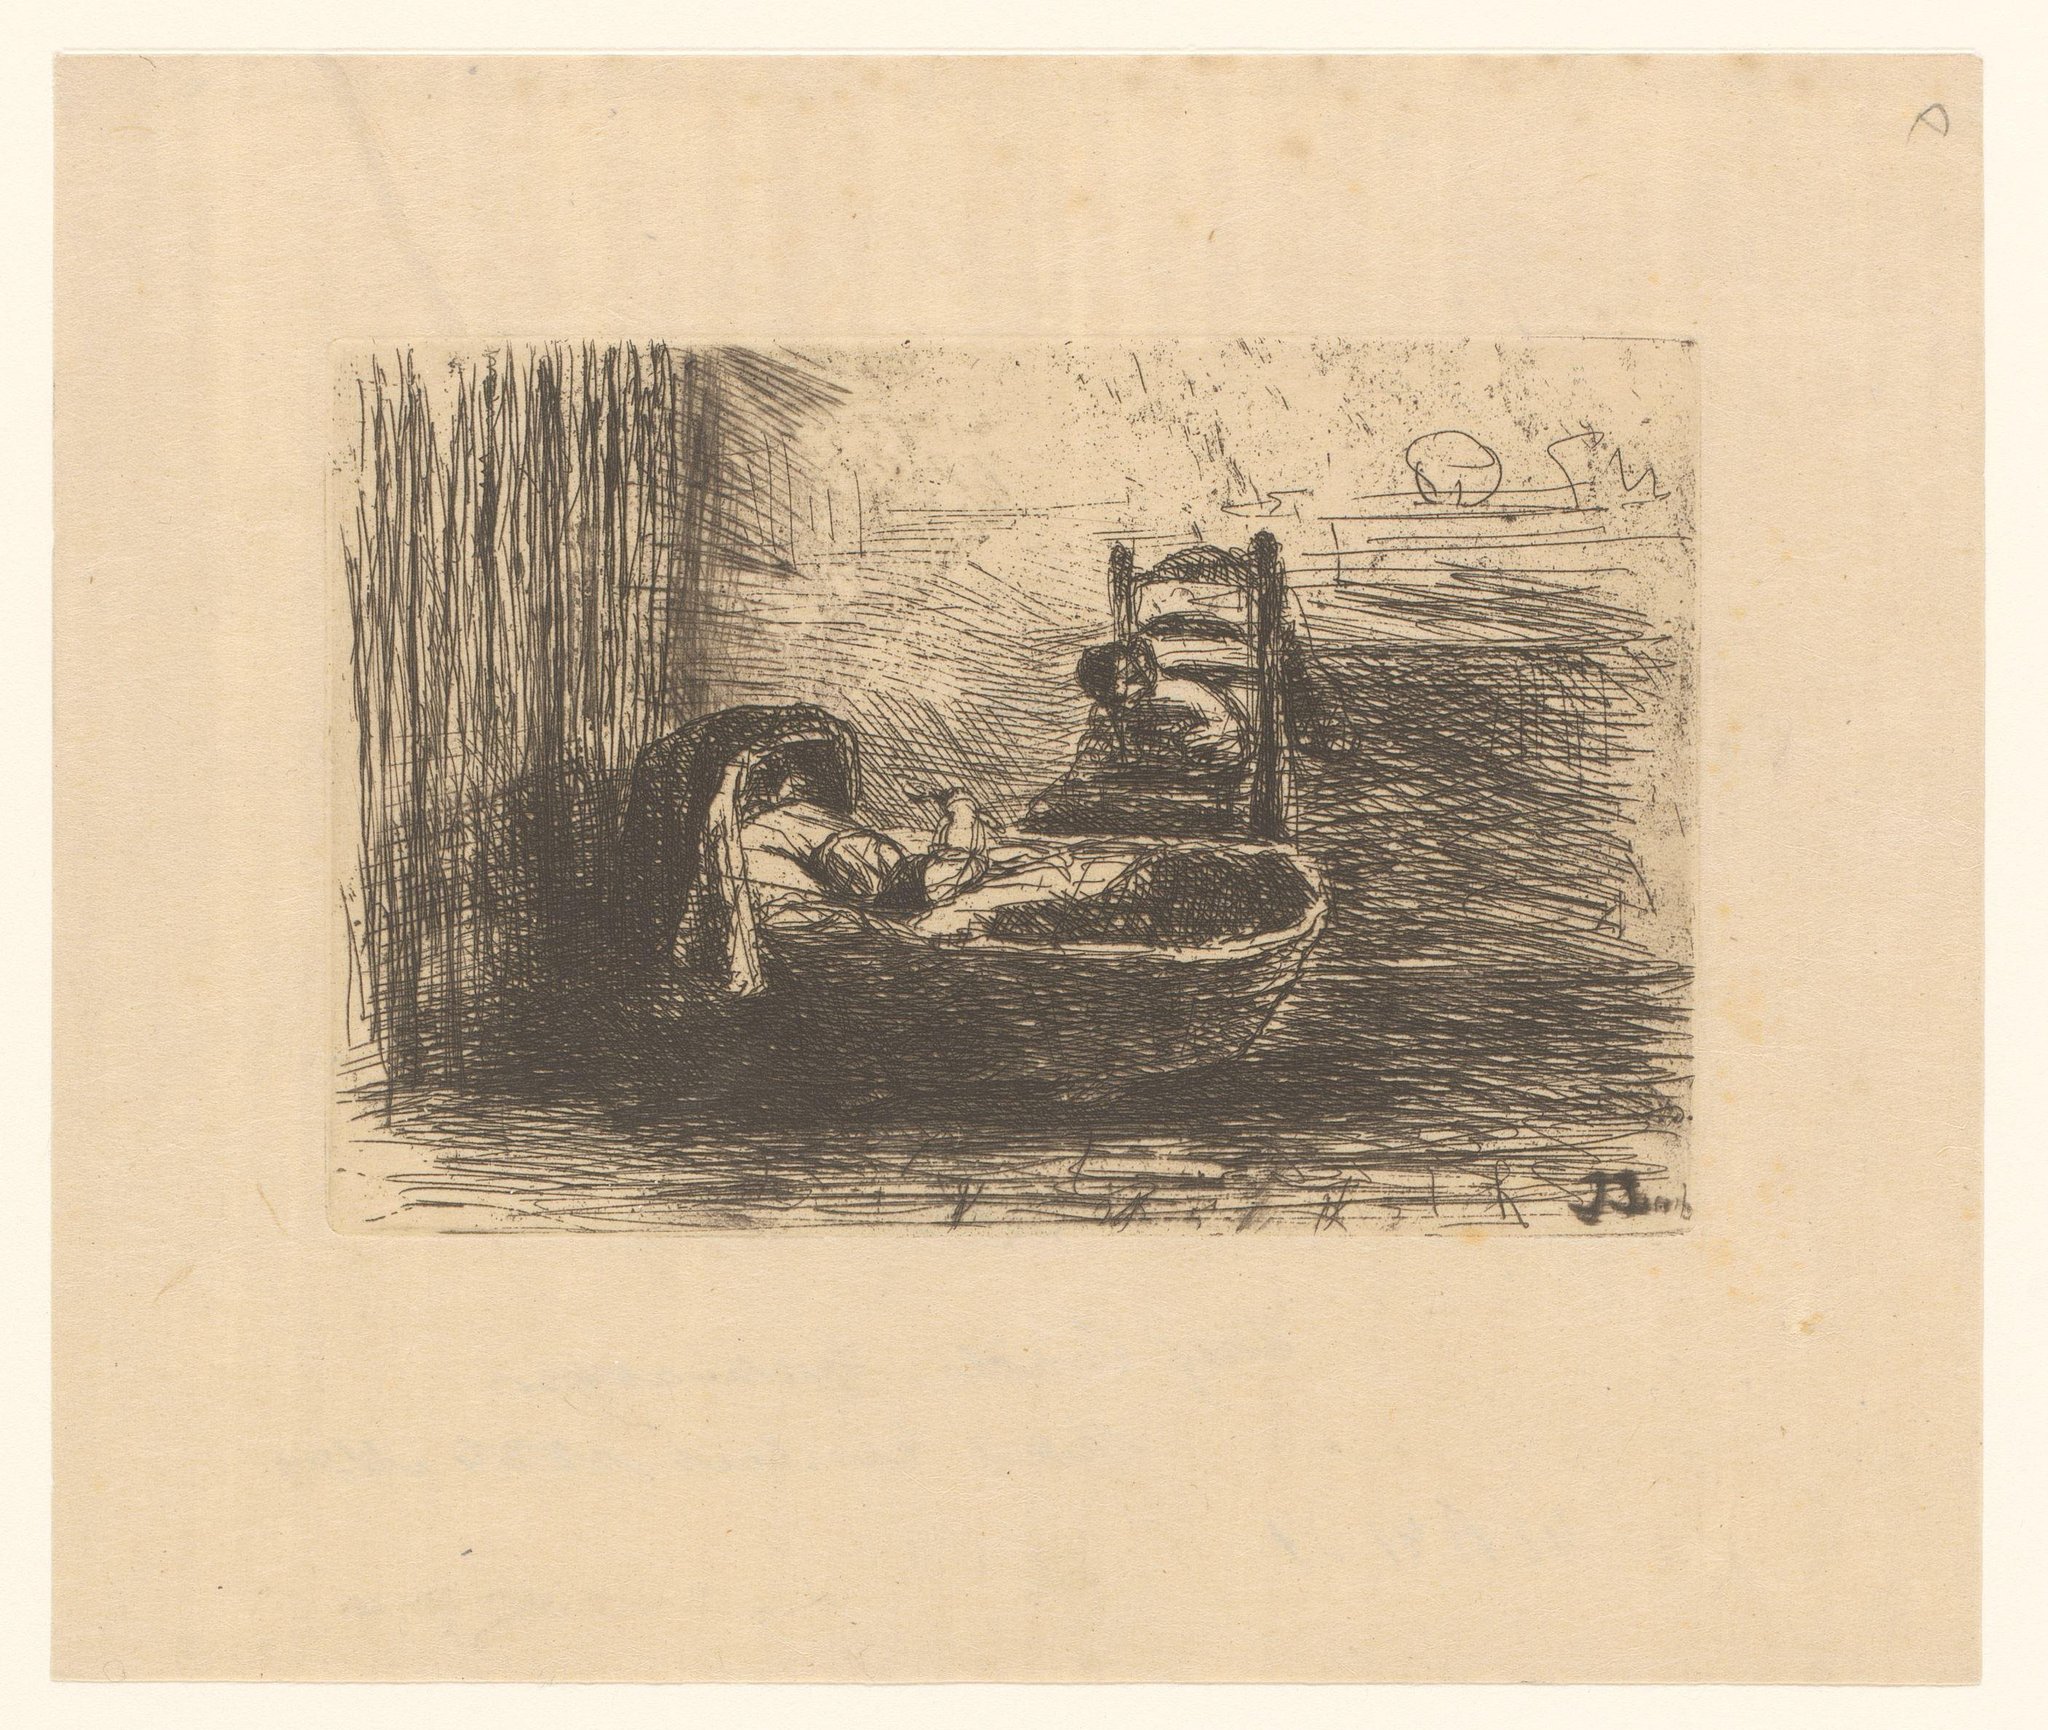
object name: print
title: Kind in een wieg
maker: jozef israëls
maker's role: draughtsman, painter, print maker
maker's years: 1824-1911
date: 1834-1911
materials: paper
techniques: etching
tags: cradle, crib, dog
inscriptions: collector's mark: Lugt 2228, inscription: ‘Jozef Israëls/ Speelmakkers/ Nederl. Etsclub 1886 No 1’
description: Maakte waarschijnlijk deel uit van de eerste portefeuille uitgegeven door de Nederlandsche Etsclub in 1886.